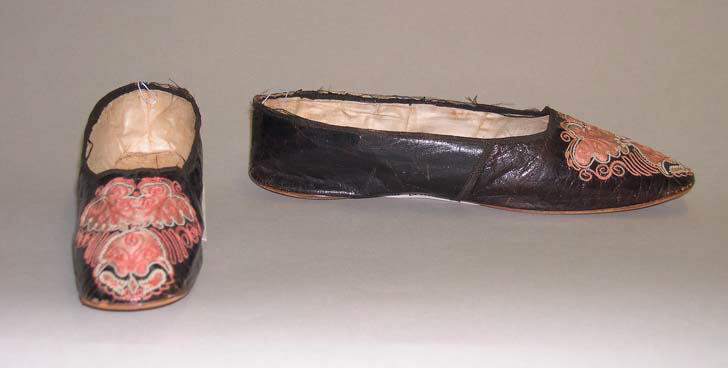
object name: slipper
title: Slippers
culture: french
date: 1850-1859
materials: leather, linen, silk